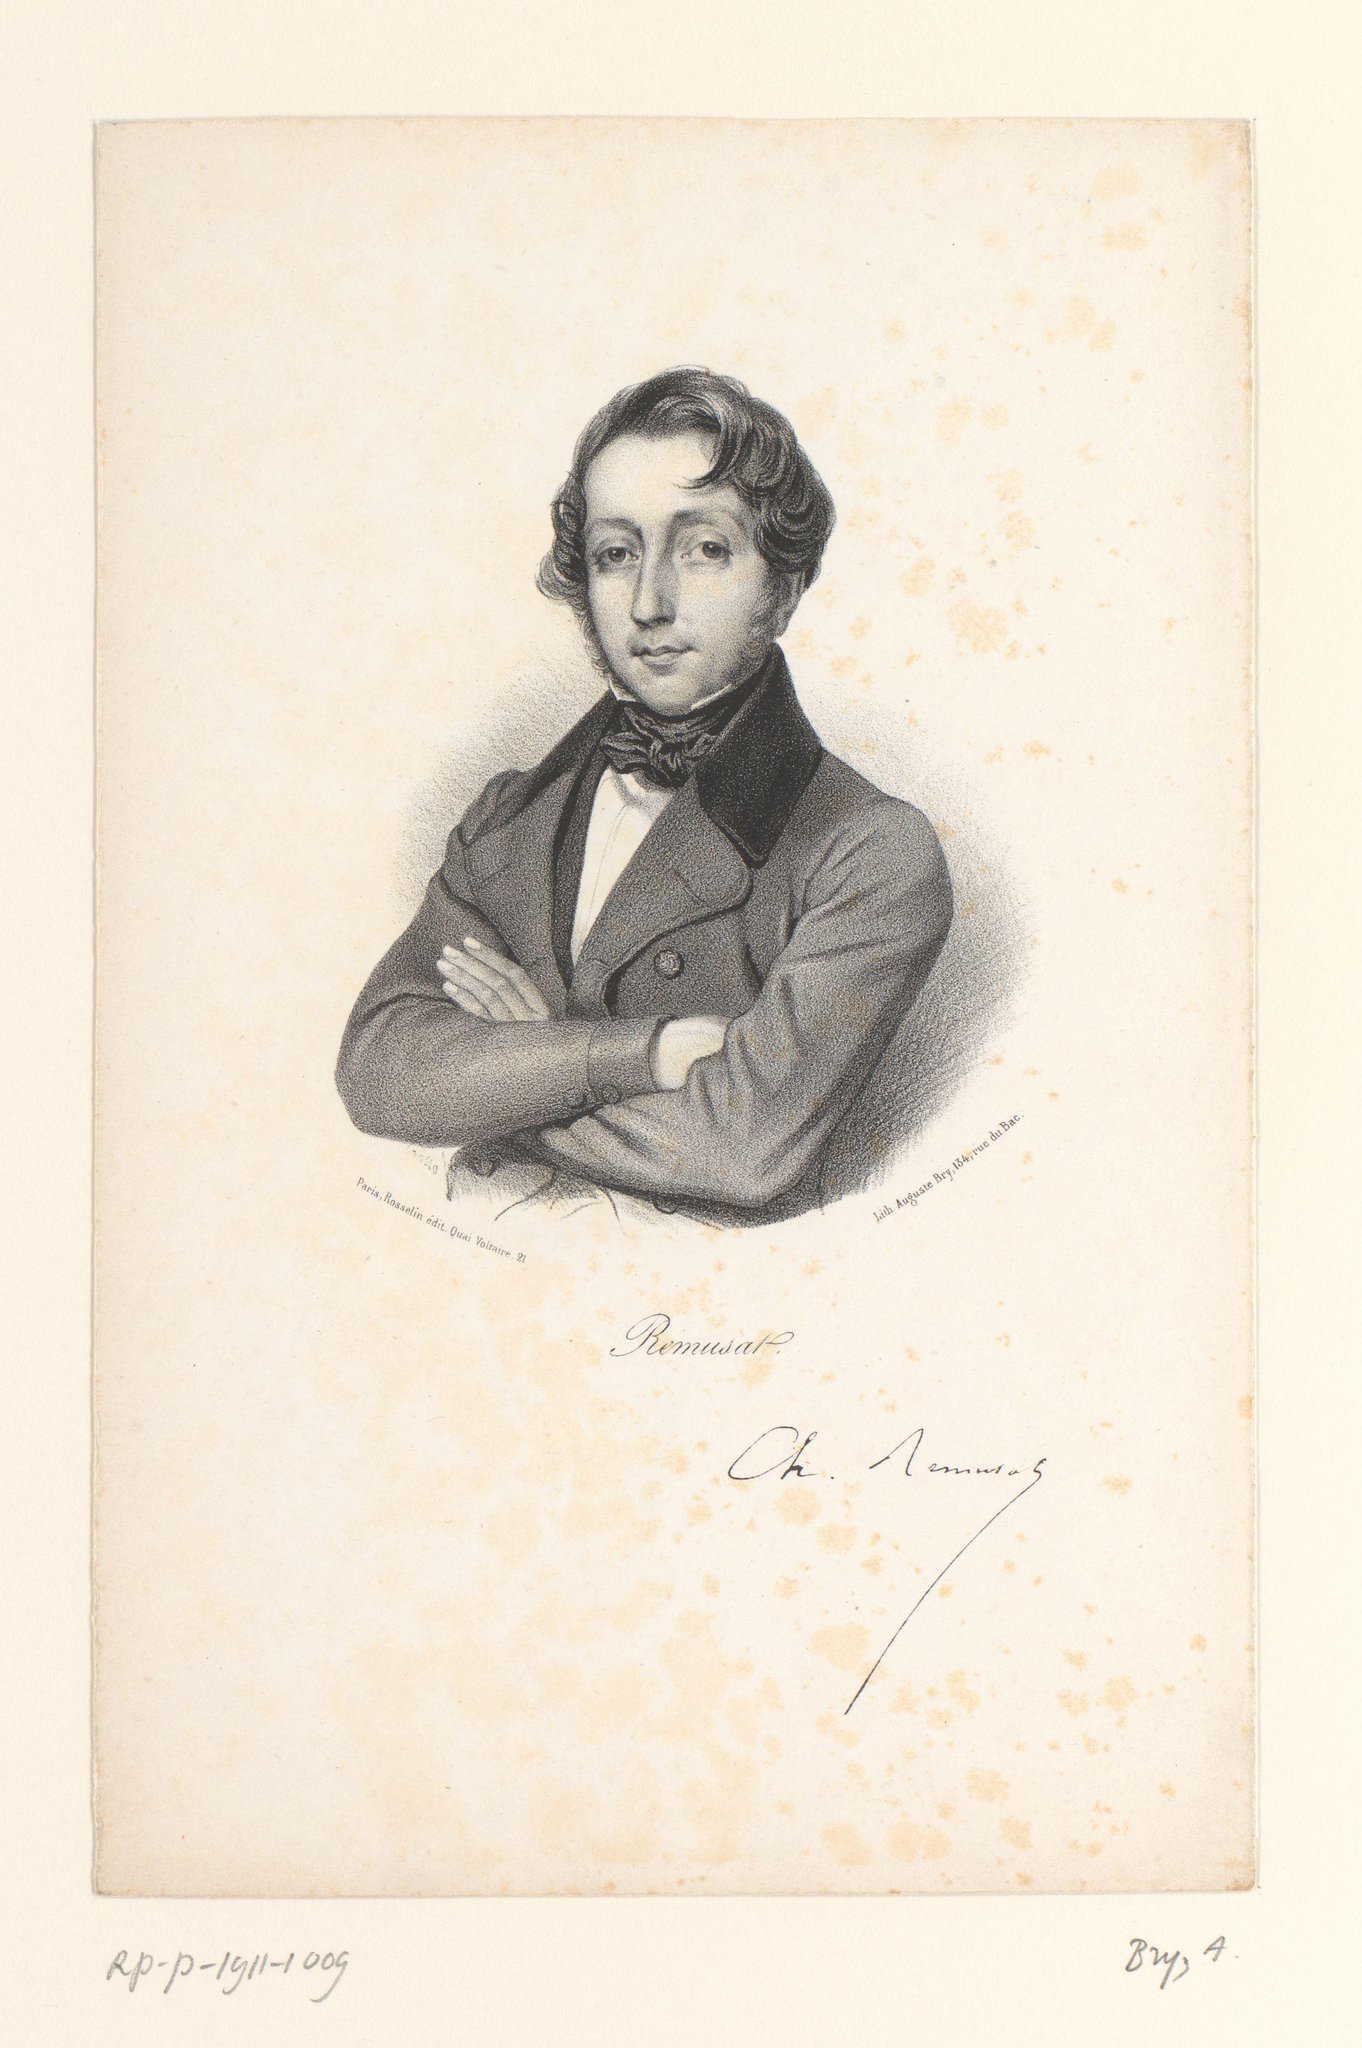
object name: print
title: Portret van de filosoof Charles de Rémusat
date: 1830-1861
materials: paper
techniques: lithograph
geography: paris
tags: paris, politician, historical persons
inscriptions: collector's mark: Lugt 2228a